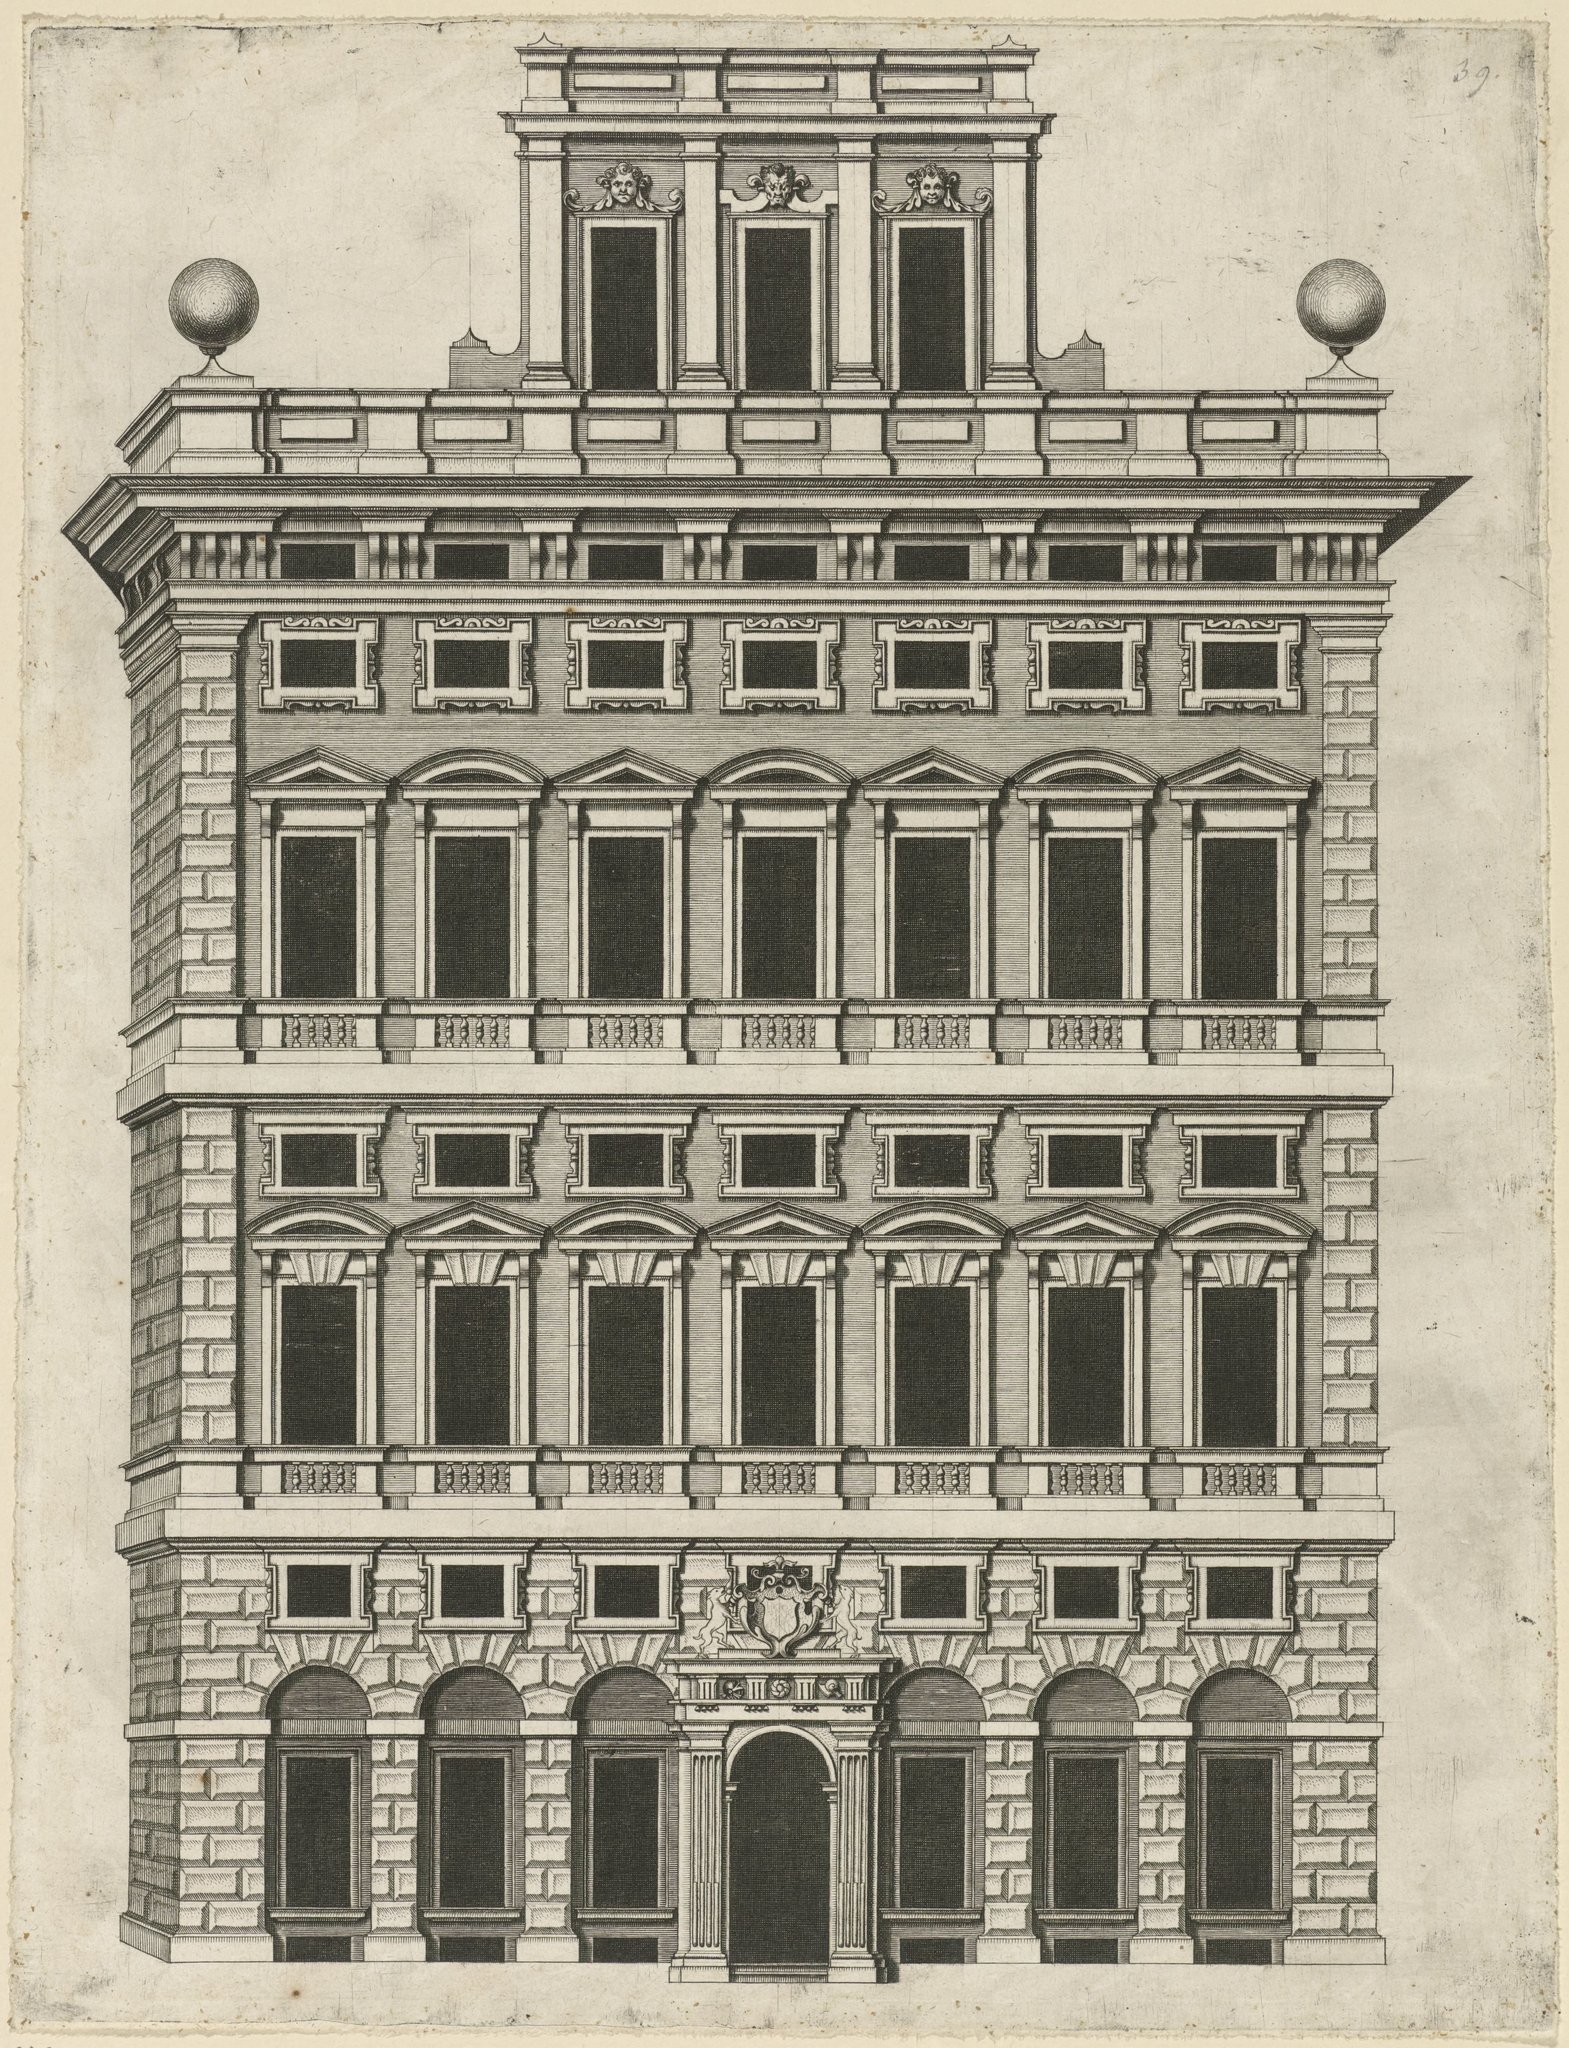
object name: print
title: Palazzo Centurione Cambiaso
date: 1622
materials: paper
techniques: engraving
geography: antwerp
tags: façade (of house or building)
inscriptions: collector's mark: Lugt 240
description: Prent gebruikt in: Peter Paul Rubens, Nicolaes Ryckmans. Palazzi di Genova. 2 dl. G. Meursio: Antwerpen, 1622, nr. 39.